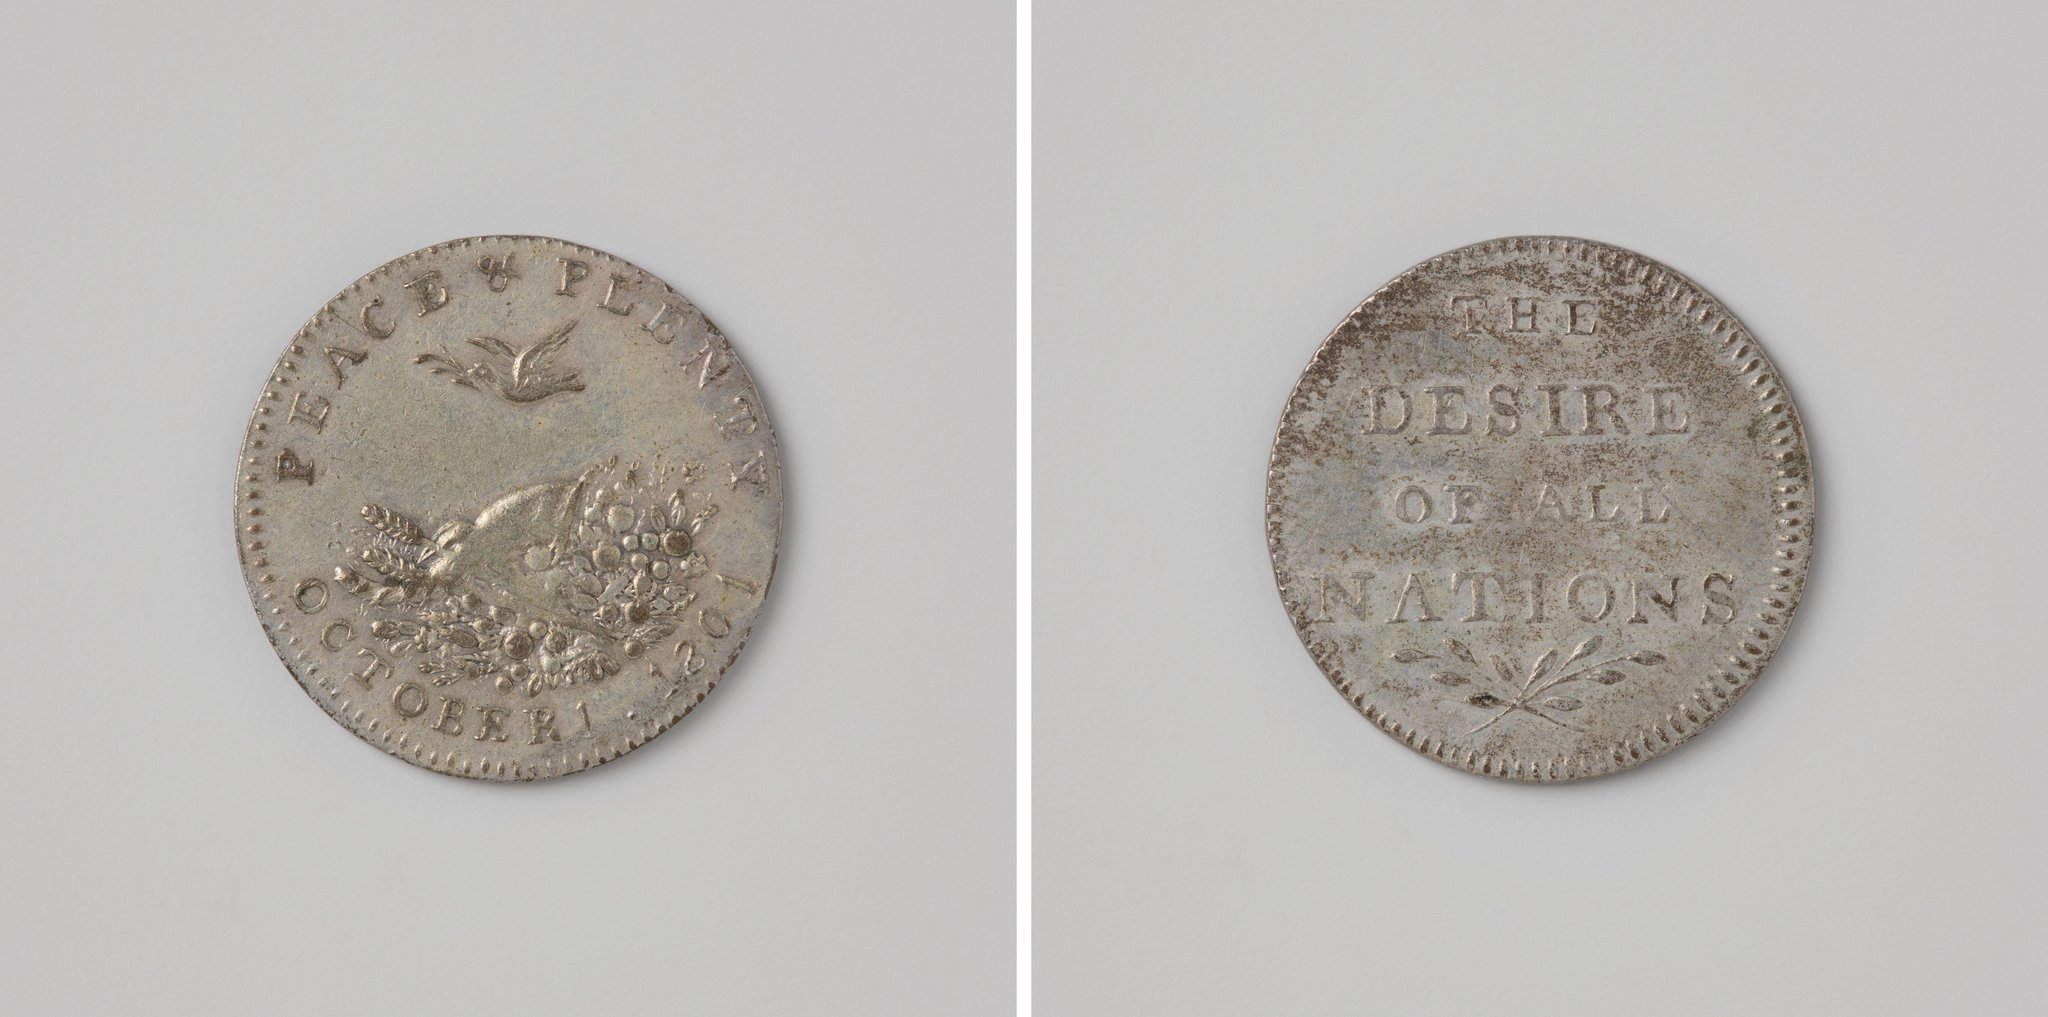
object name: strooipenning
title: Vrede van Luneville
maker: Anonymous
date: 1801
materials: silver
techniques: striking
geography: england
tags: lunéville, tweede coalitie-oorlog, franse revolutie, vrede van lunéville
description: Zilveren penning. Voorzijde: gevulde hoorn van overvloed, waarop dolk ligt; daarboven duif met olijftak in bek binnen omschrift. Keerzijde: opschrift boven twee olijftakjes